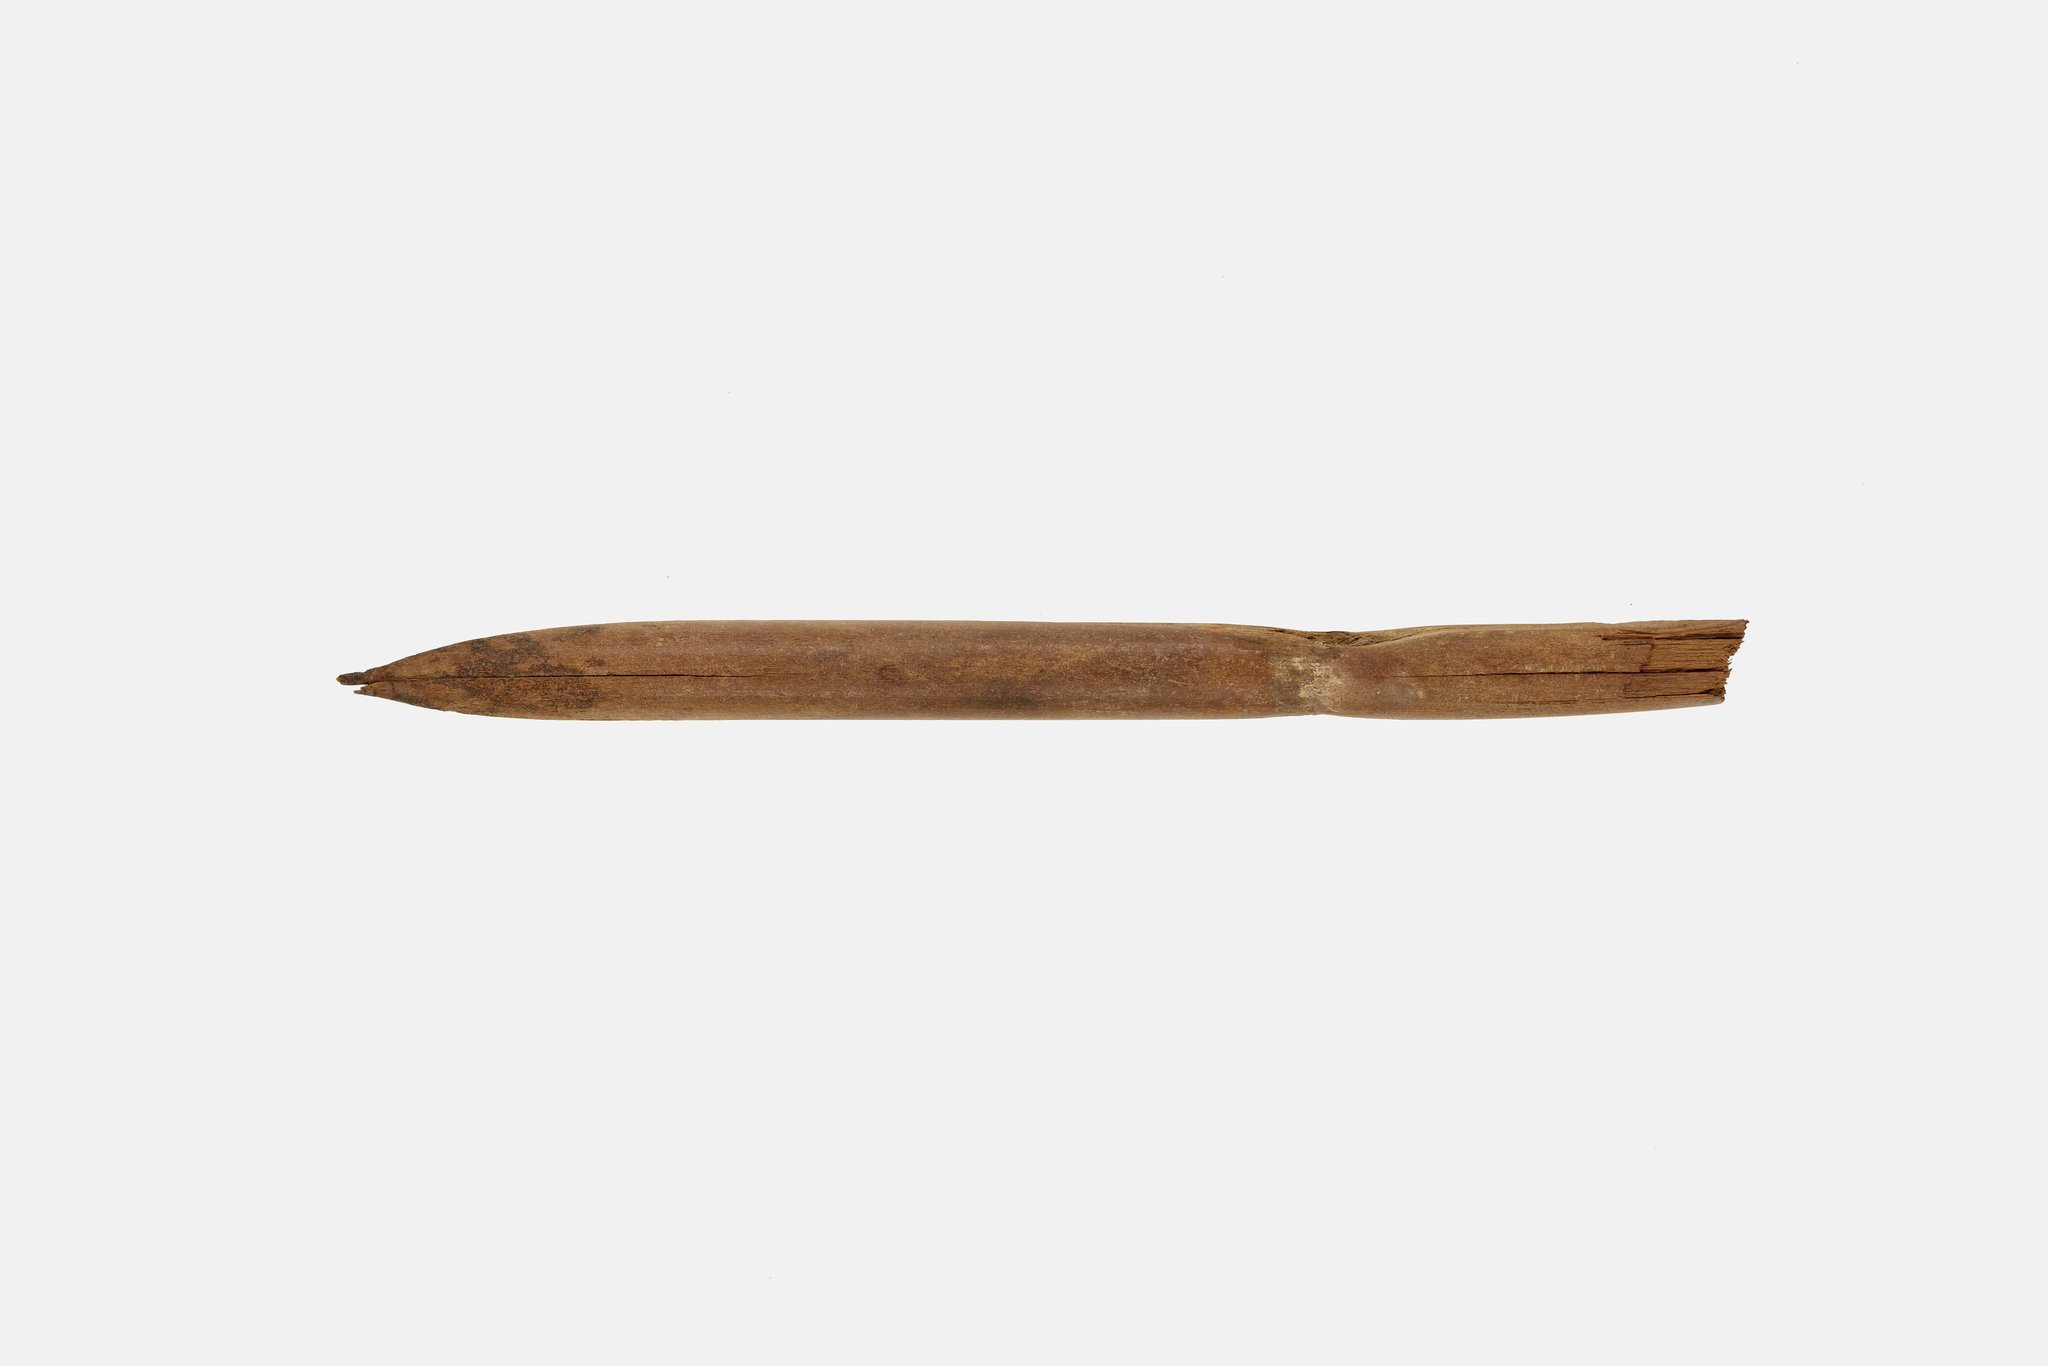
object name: pen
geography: egypt